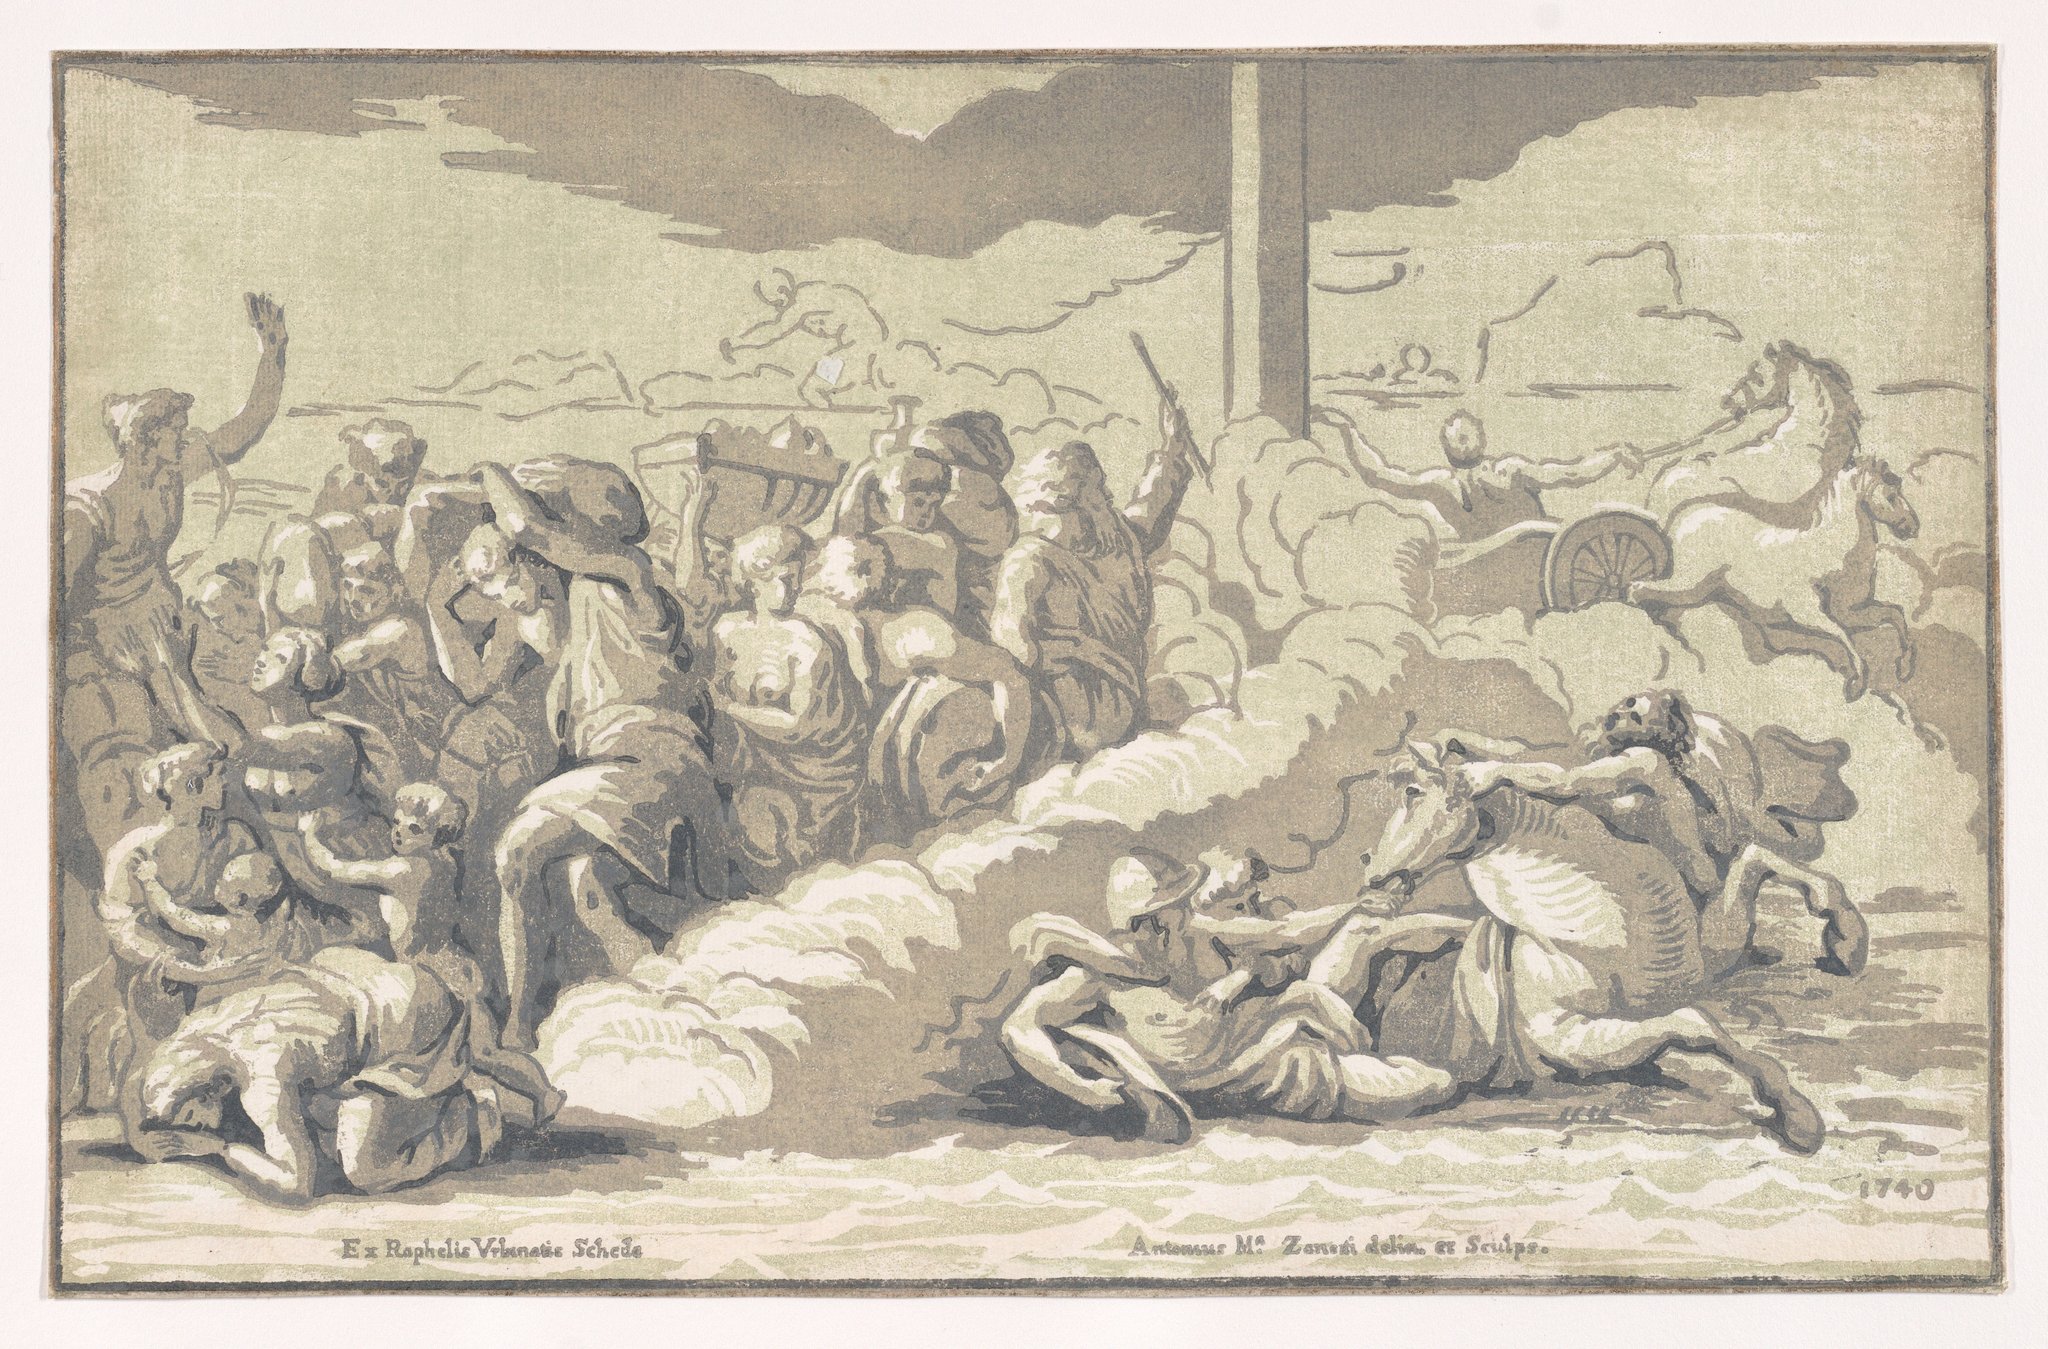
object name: print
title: The Israelites Passing the Red Sea, from Diversarum Iconum...Series Secunda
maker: conte anton maria zanetti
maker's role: artist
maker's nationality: italian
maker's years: 1680-1767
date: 1740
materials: ink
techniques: woodcut